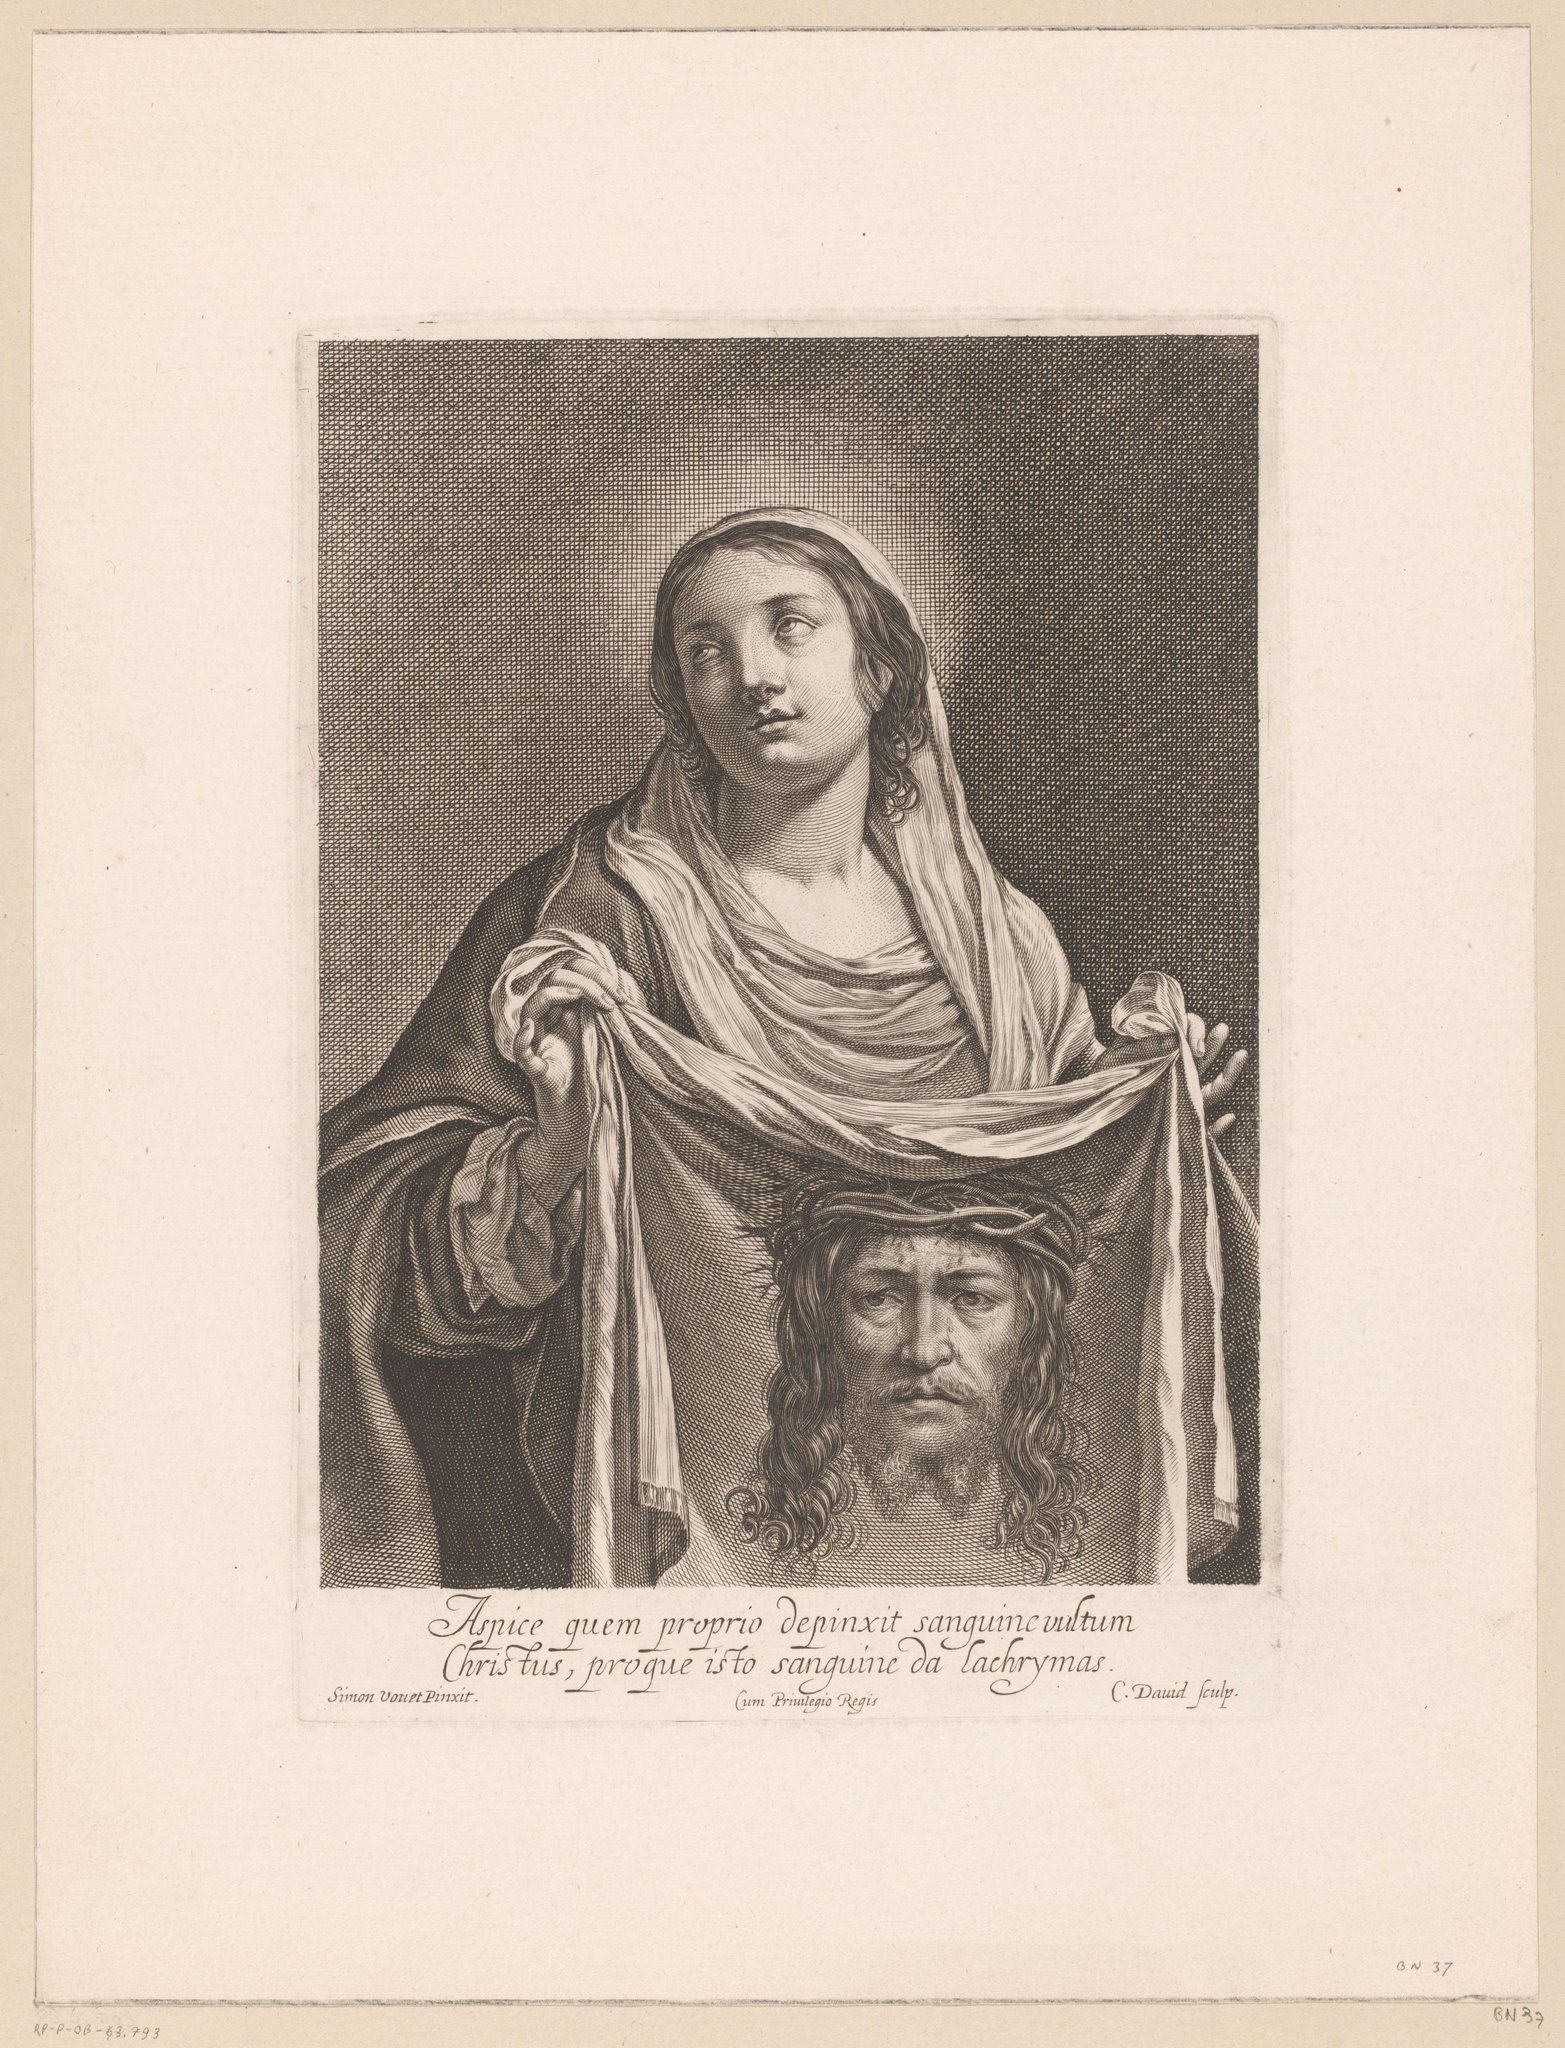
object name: print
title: H. Veronica met de zweetdoek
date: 1605-1643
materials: paper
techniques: engraving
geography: france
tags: 'vera icon', held up by veronica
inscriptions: collector's mark: Lugt 240